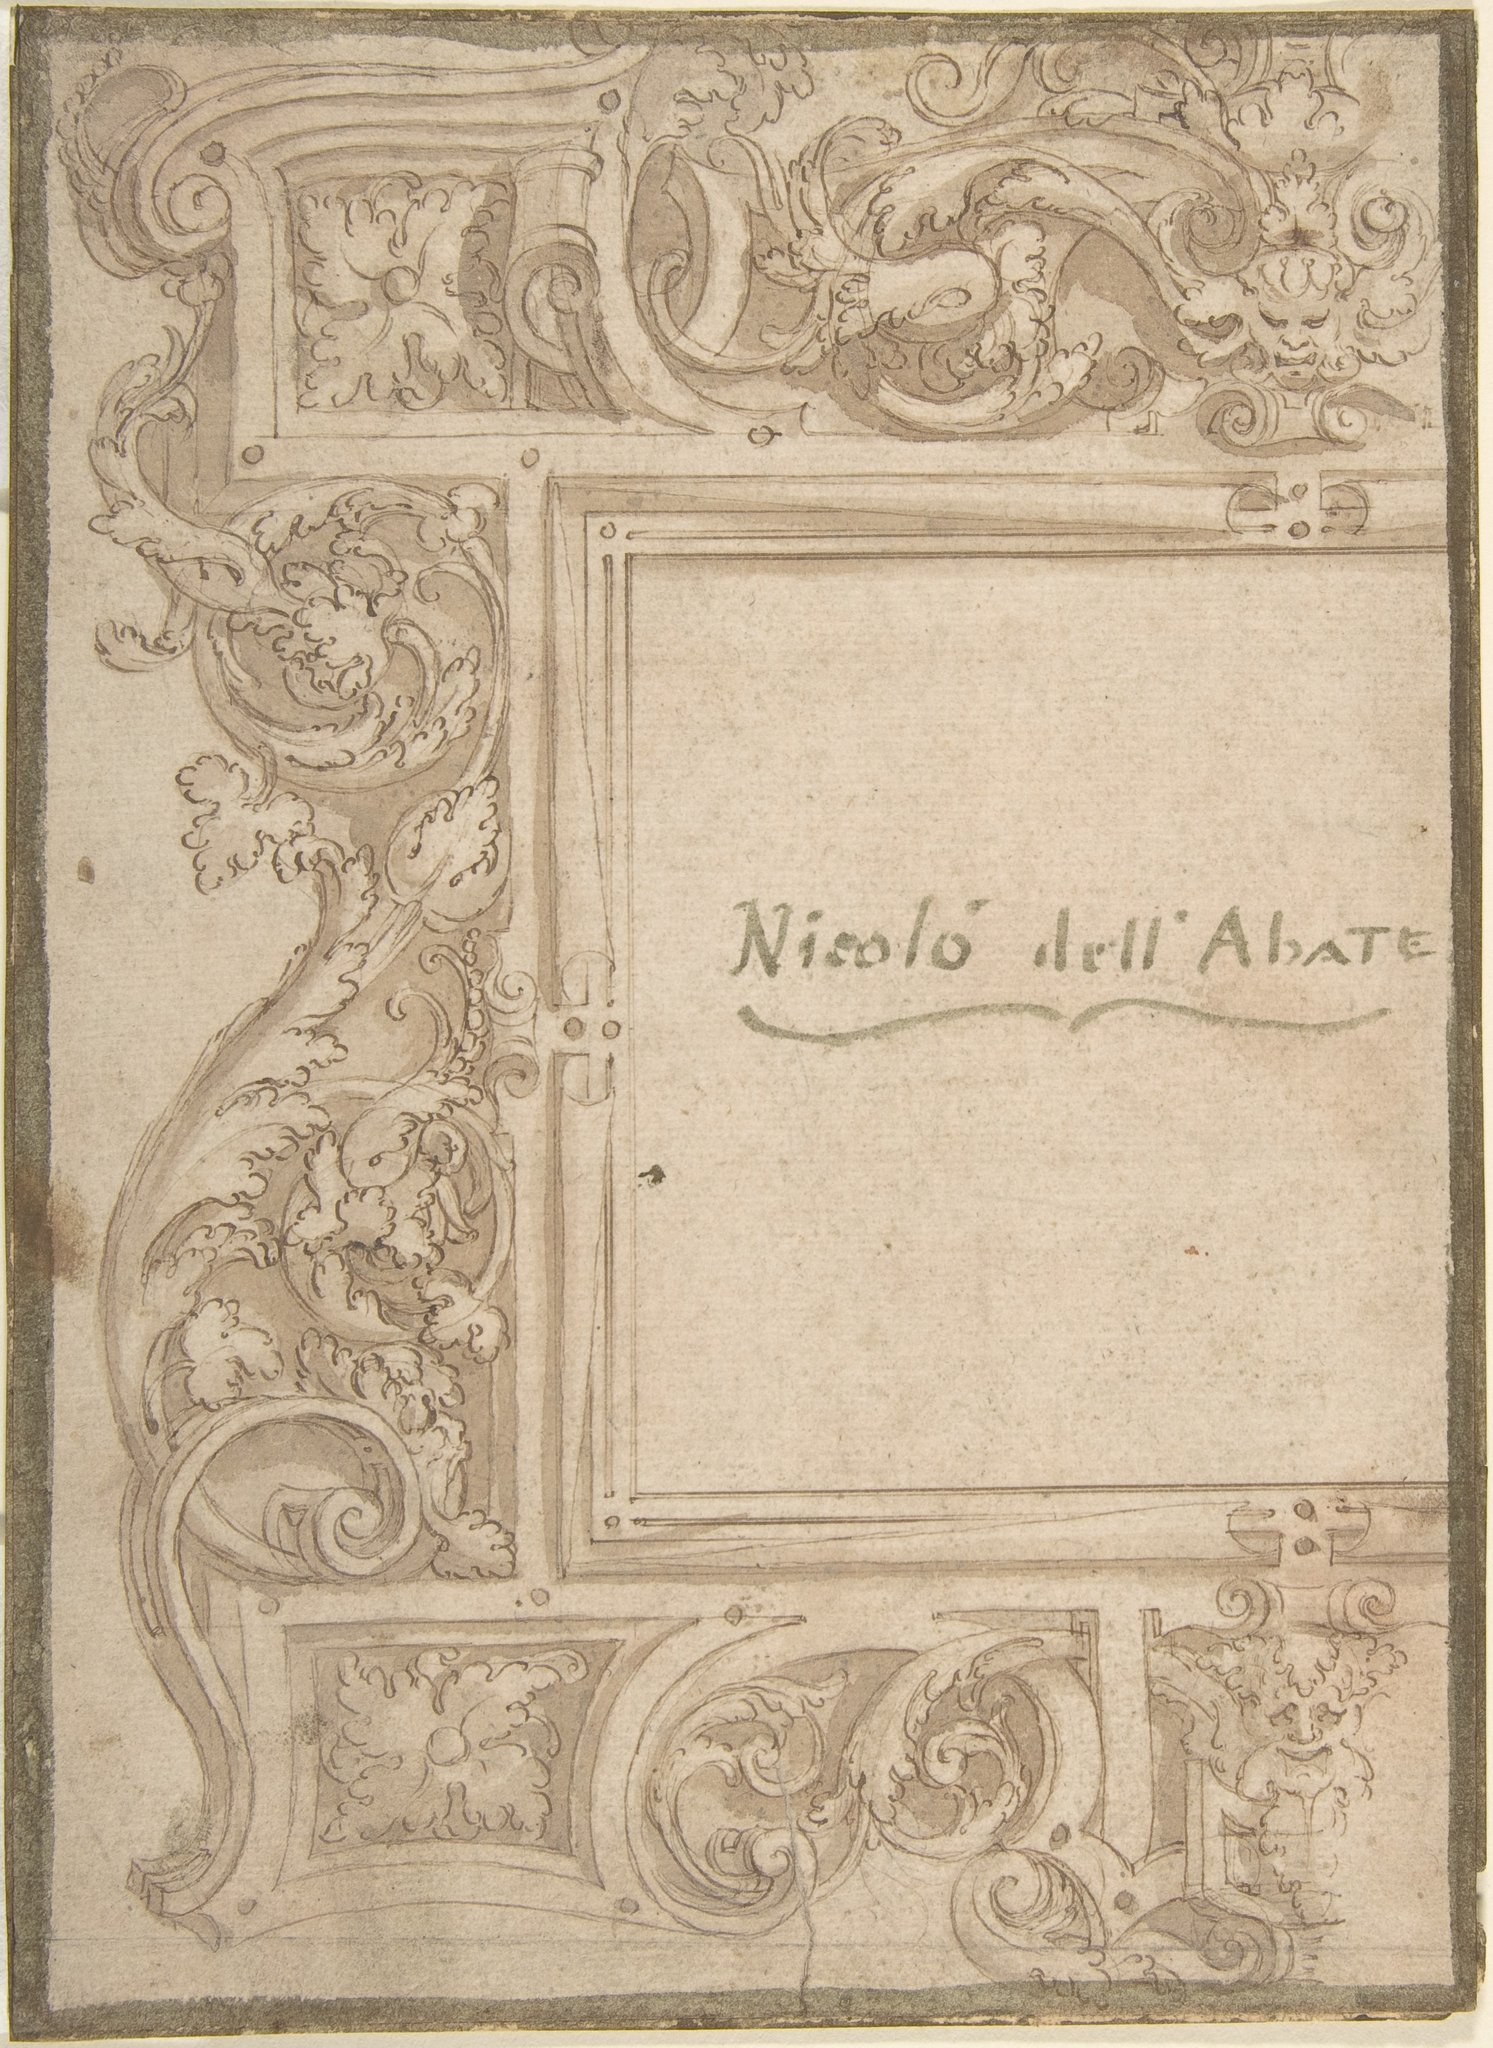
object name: drawing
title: Design for a Cartouche (recto); Fragments of the Plan of a Building (Church?) (verso)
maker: anonymous, italian, 16th century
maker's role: artist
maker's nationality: italian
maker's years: 1550-1600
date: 1501-1600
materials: ink, drawing material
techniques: brush, pen, wash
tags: architecture,cartouches